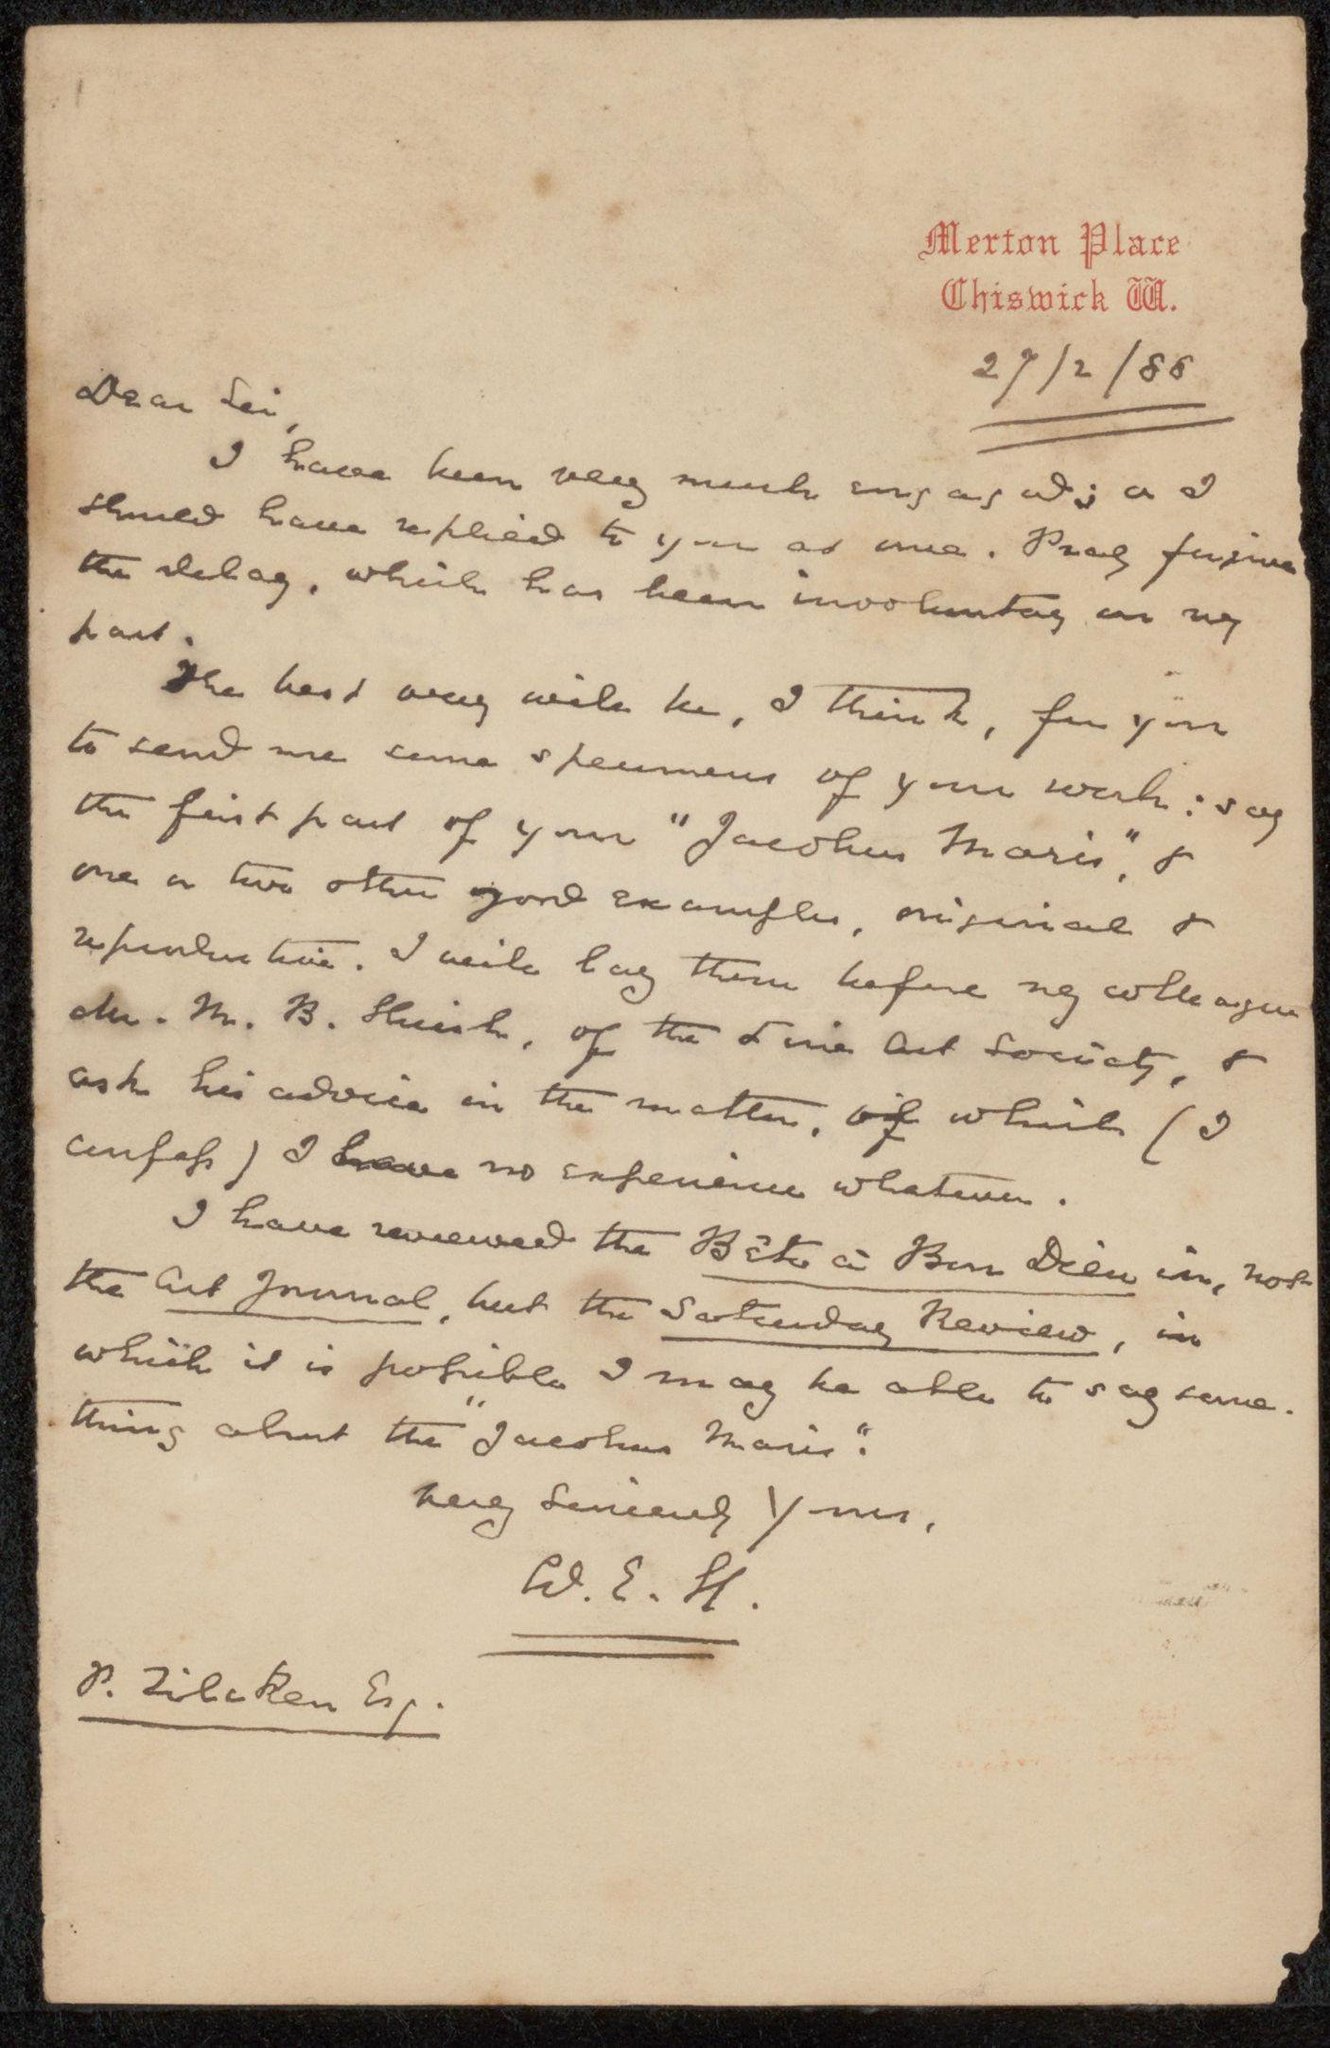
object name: letter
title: Brief aan Philip Zilcken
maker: william ernest henley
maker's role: criticus, dichter, redacteur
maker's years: 1849-1903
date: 1888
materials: ink, paper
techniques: pen, printing, writing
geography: chiswick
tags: the hague, painter, draughtsman, philip zilcken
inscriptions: collector's mark: ‘RPK’